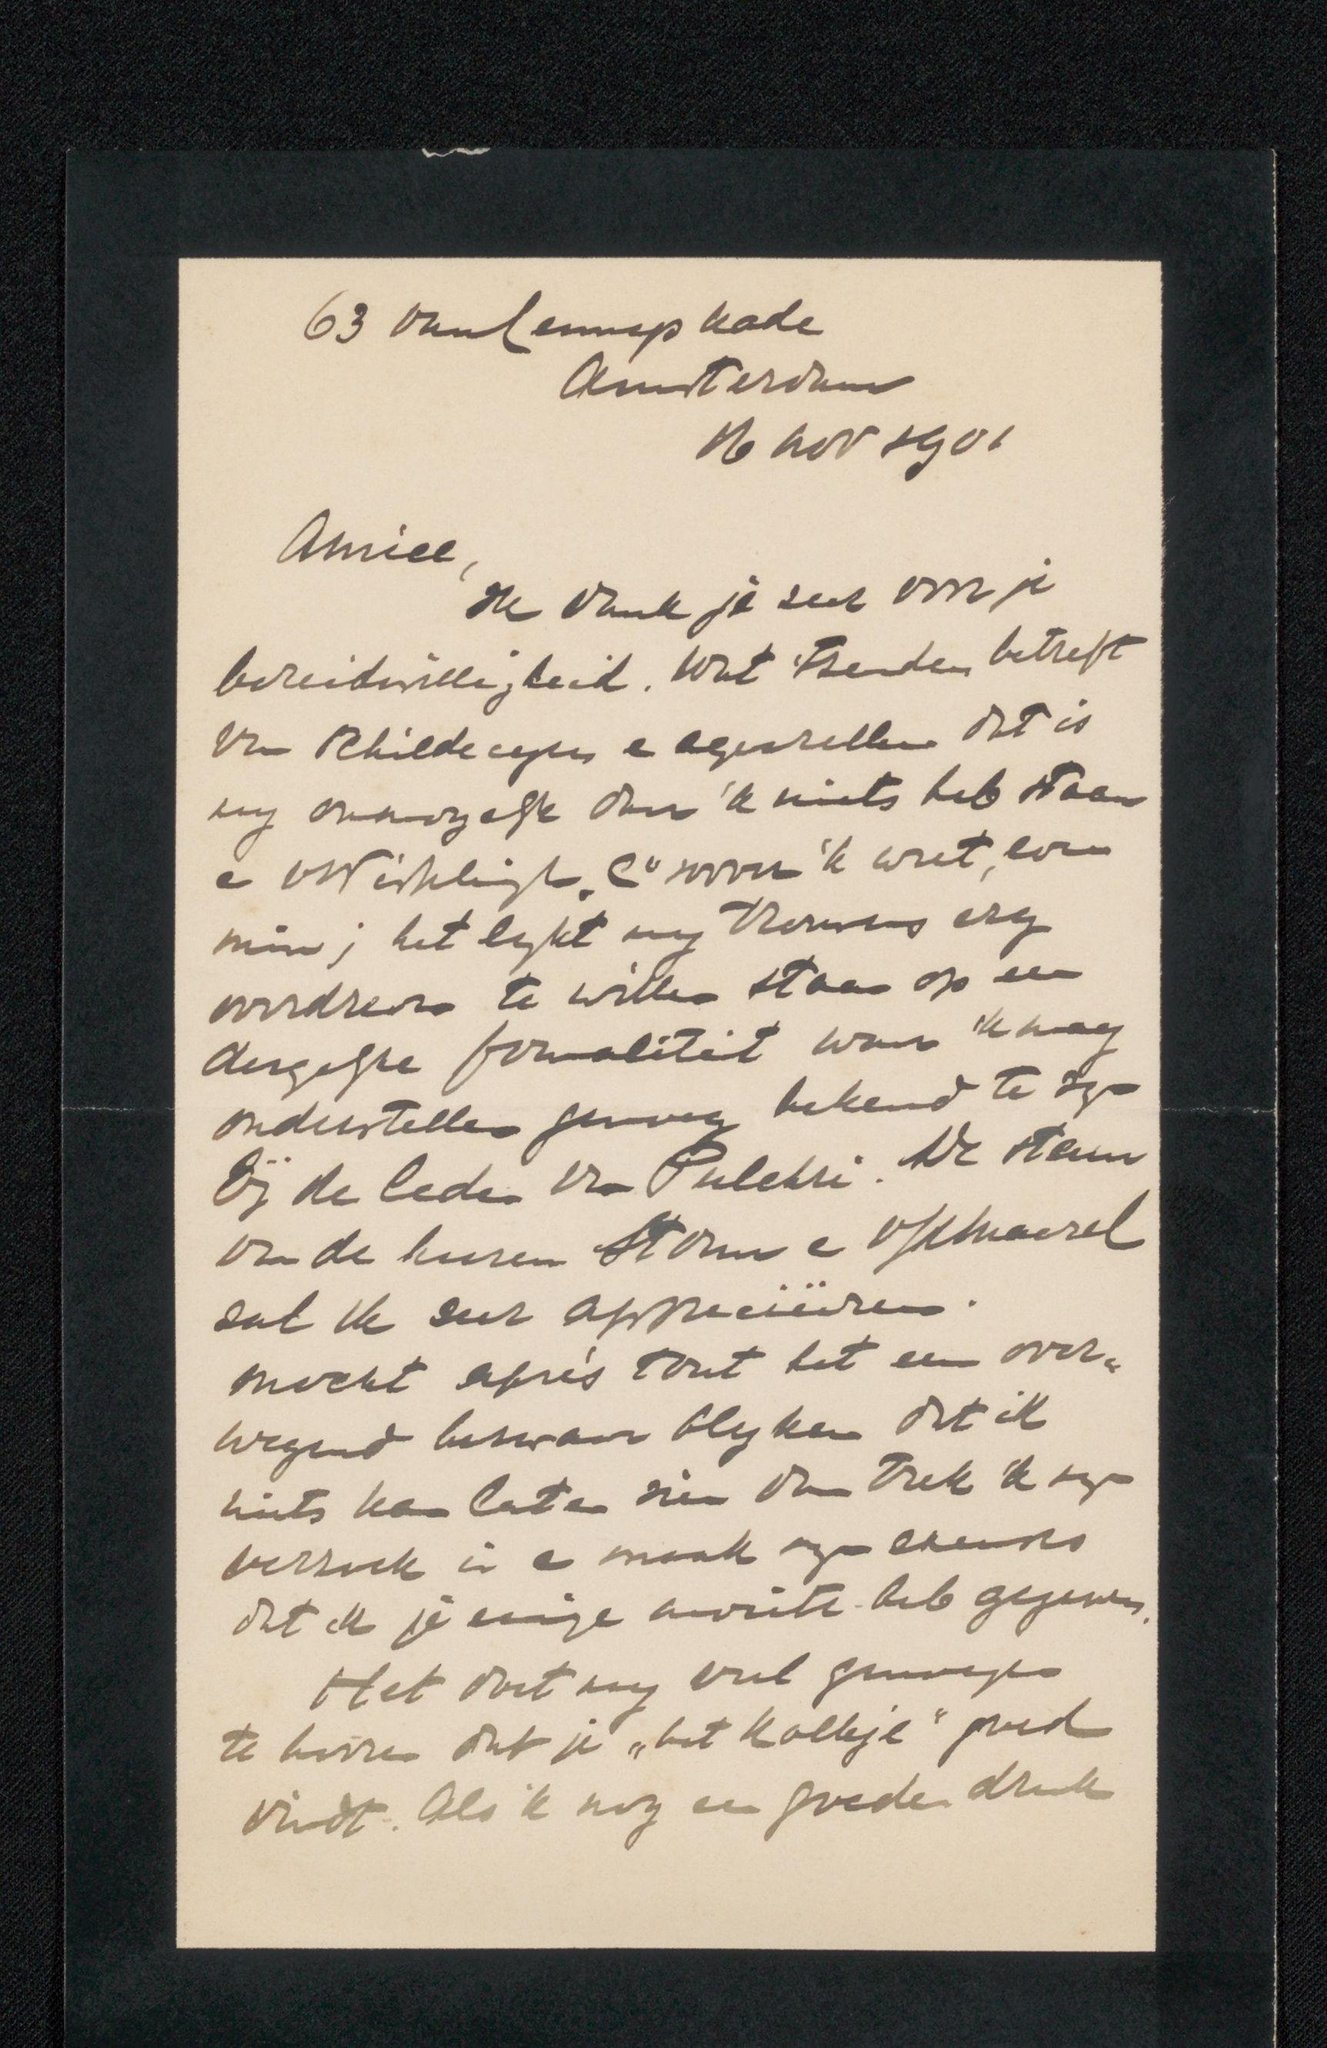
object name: letter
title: Brief aan Philip Zilcken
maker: willem witsen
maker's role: draughtsman, painter, print maker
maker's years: 1860-1923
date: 1901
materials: ink, paper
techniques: pen, writing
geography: ede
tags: print maker, carel nicolaas storm van 's-gravesande, the hague, painter, draughtsman, marinus van der maarel, philip zilcken, drawing, the graphic arts, painting (including book-illumination, miniature-painting)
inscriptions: collector's mark: ‘RPK’